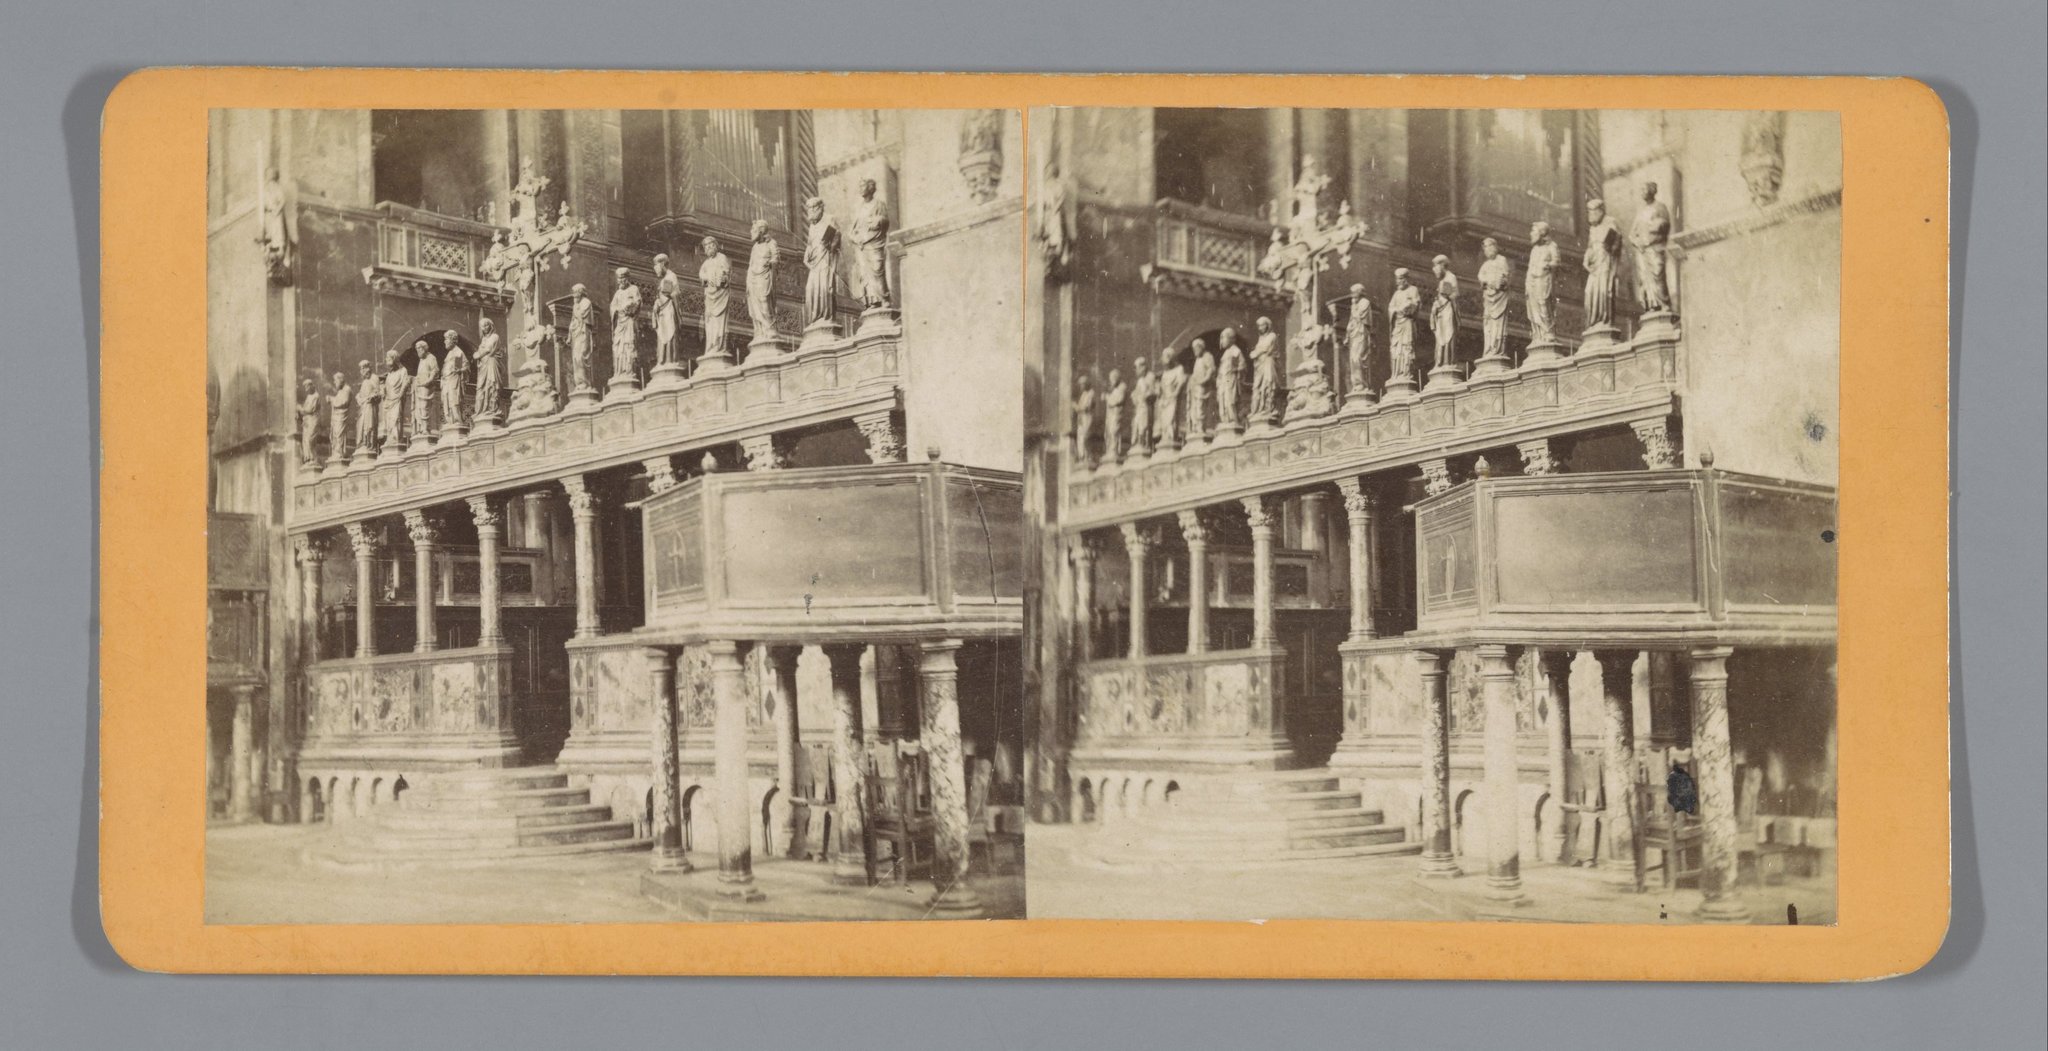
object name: stereograph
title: Oksaal en preekstoel in de Basiliek van San Marco te Venetië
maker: Anonymous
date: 1850-1880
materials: cardboard, photographic support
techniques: albumen print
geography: st. mark's basilica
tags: rood-screen, choir-screen; iconostasis, interior of church, pulpit, ambo, chancel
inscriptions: inscription: ‘de twaalf apostelen [...] Maria e Margaretha Ingang van het koor in de St marcuskerk’